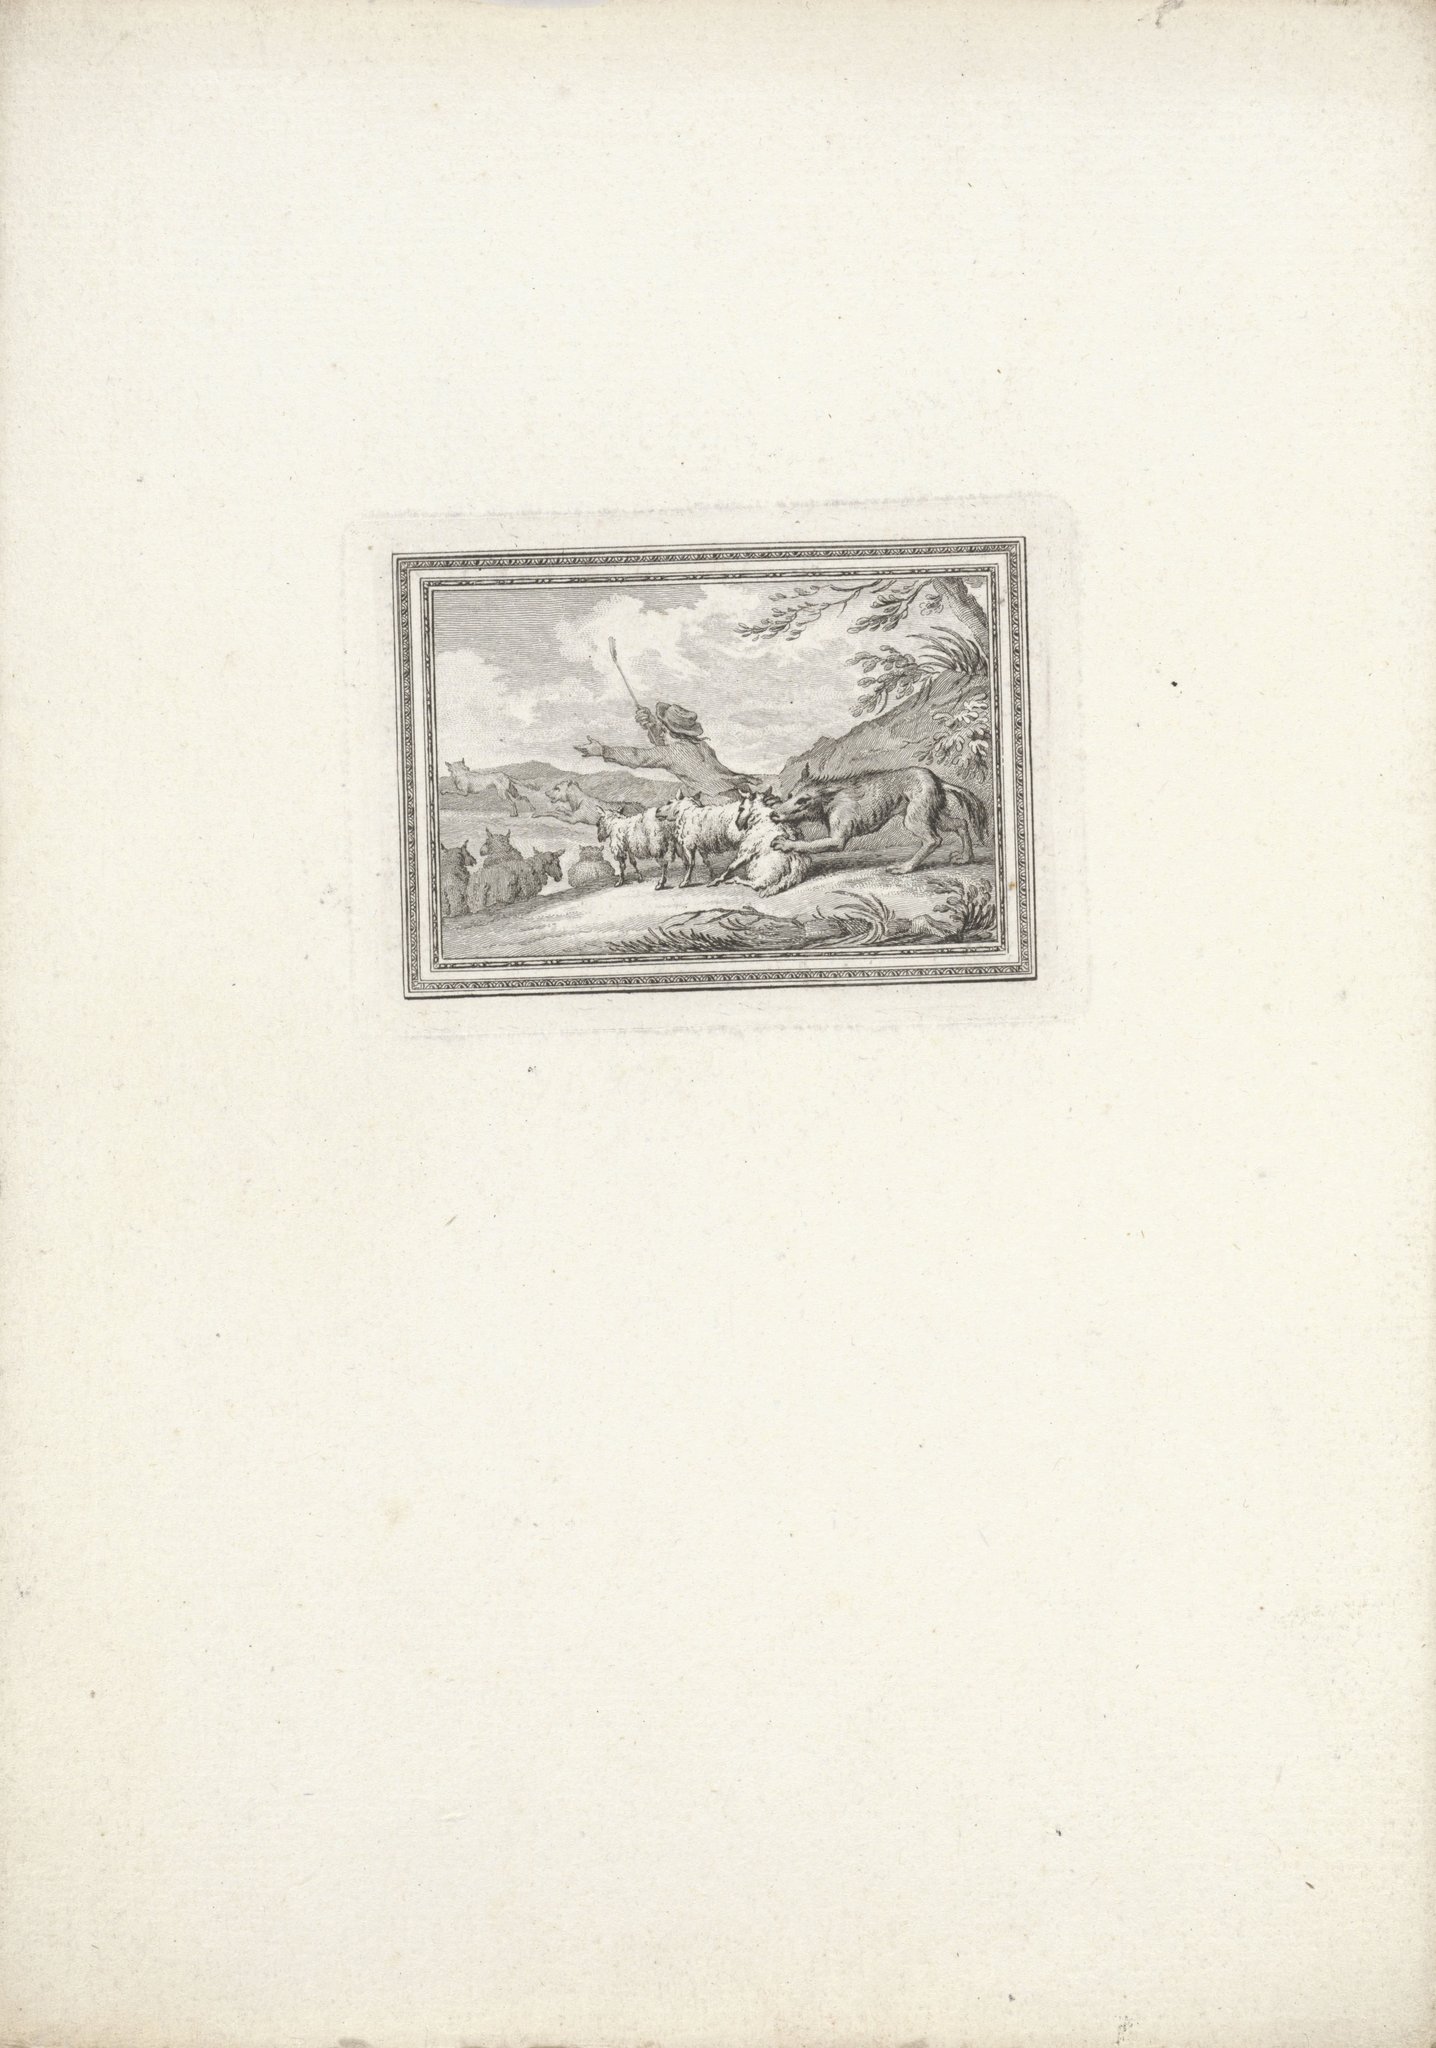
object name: print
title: Twee wolven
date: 1792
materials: paper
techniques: etching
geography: amsterdam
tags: herding, herdsman, herdswoman, shepherd, shepherdess, cowherd, etc., sheep, beasts of prey, predatory animals: wolf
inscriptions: collector's mark: Lugt 2228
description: Een herder jaagt een wolf op terwijl een tweede wolf een van zijn schapen in de nek grijpt. Illustratie bij het verhaal 'De twee wolven' uit 'Fabelen voor de Nederlandsche jeugd'.